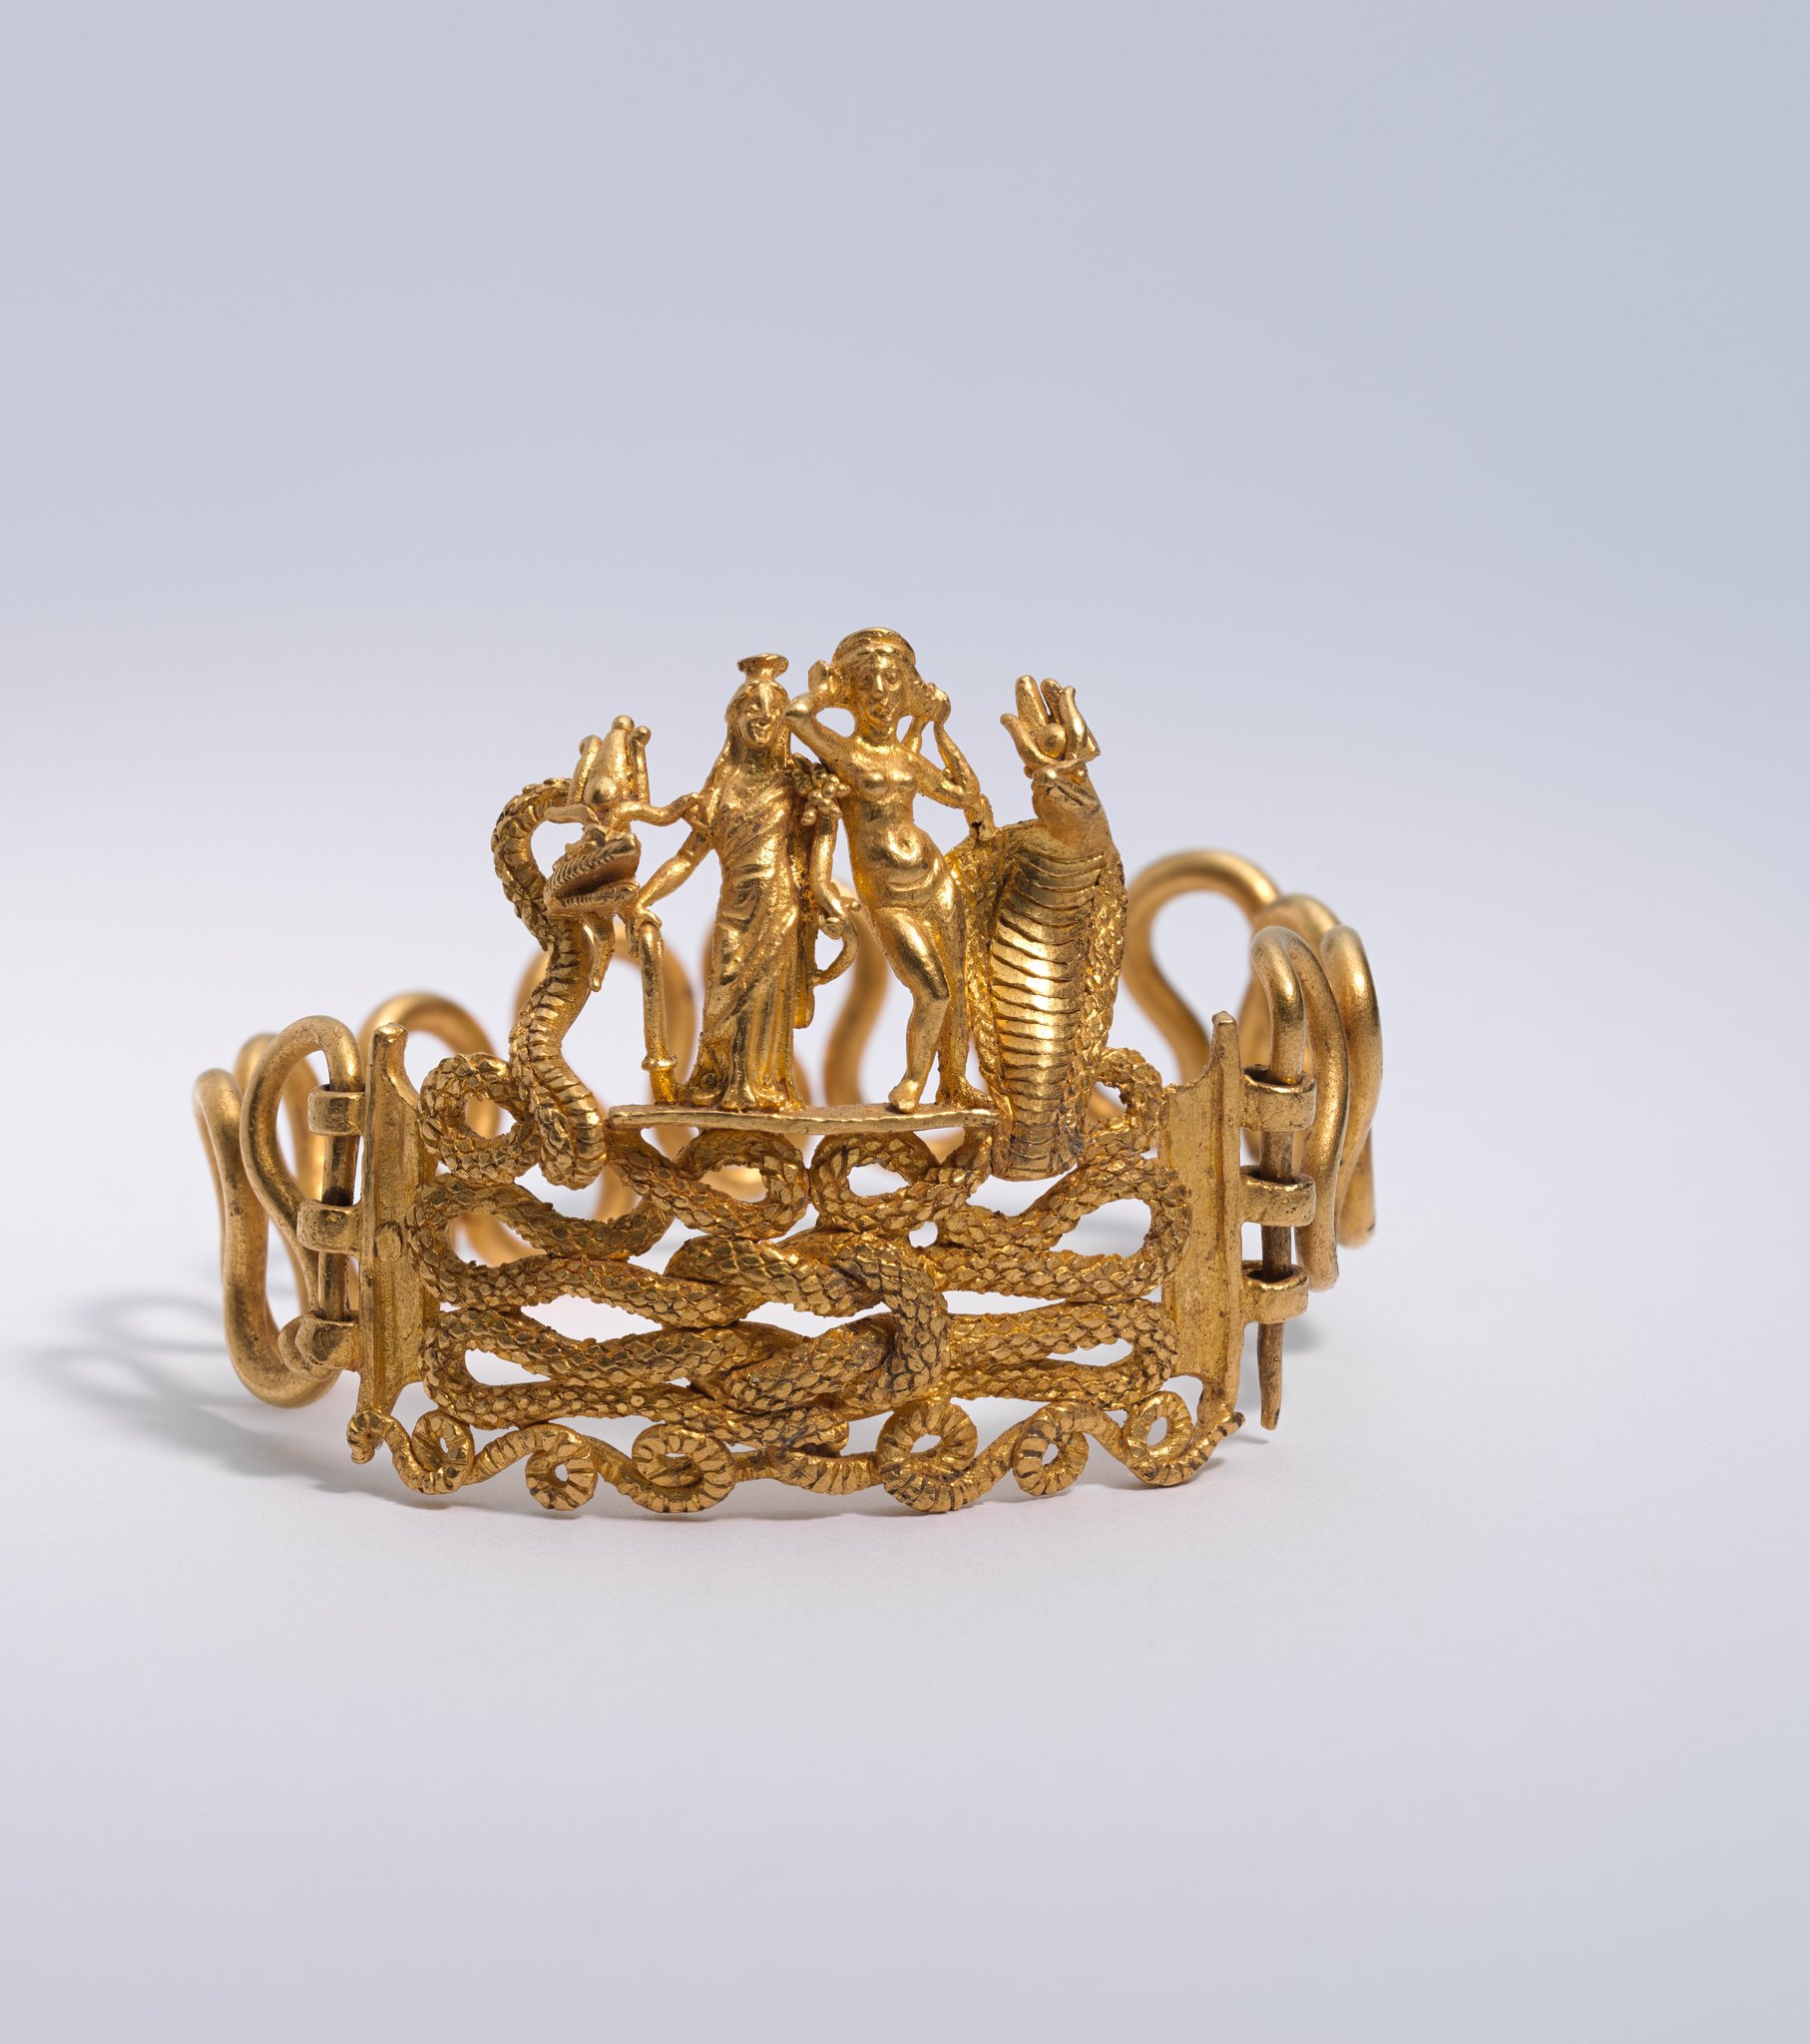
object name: bracelet, agathodaimon, isi tyche, aphrodite, thermouthis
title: Bracelet with Agathodaimon, Isis-Tyche, Aphrodite, and Thermouthis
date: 1-100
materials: gold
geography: egypt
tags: snakes